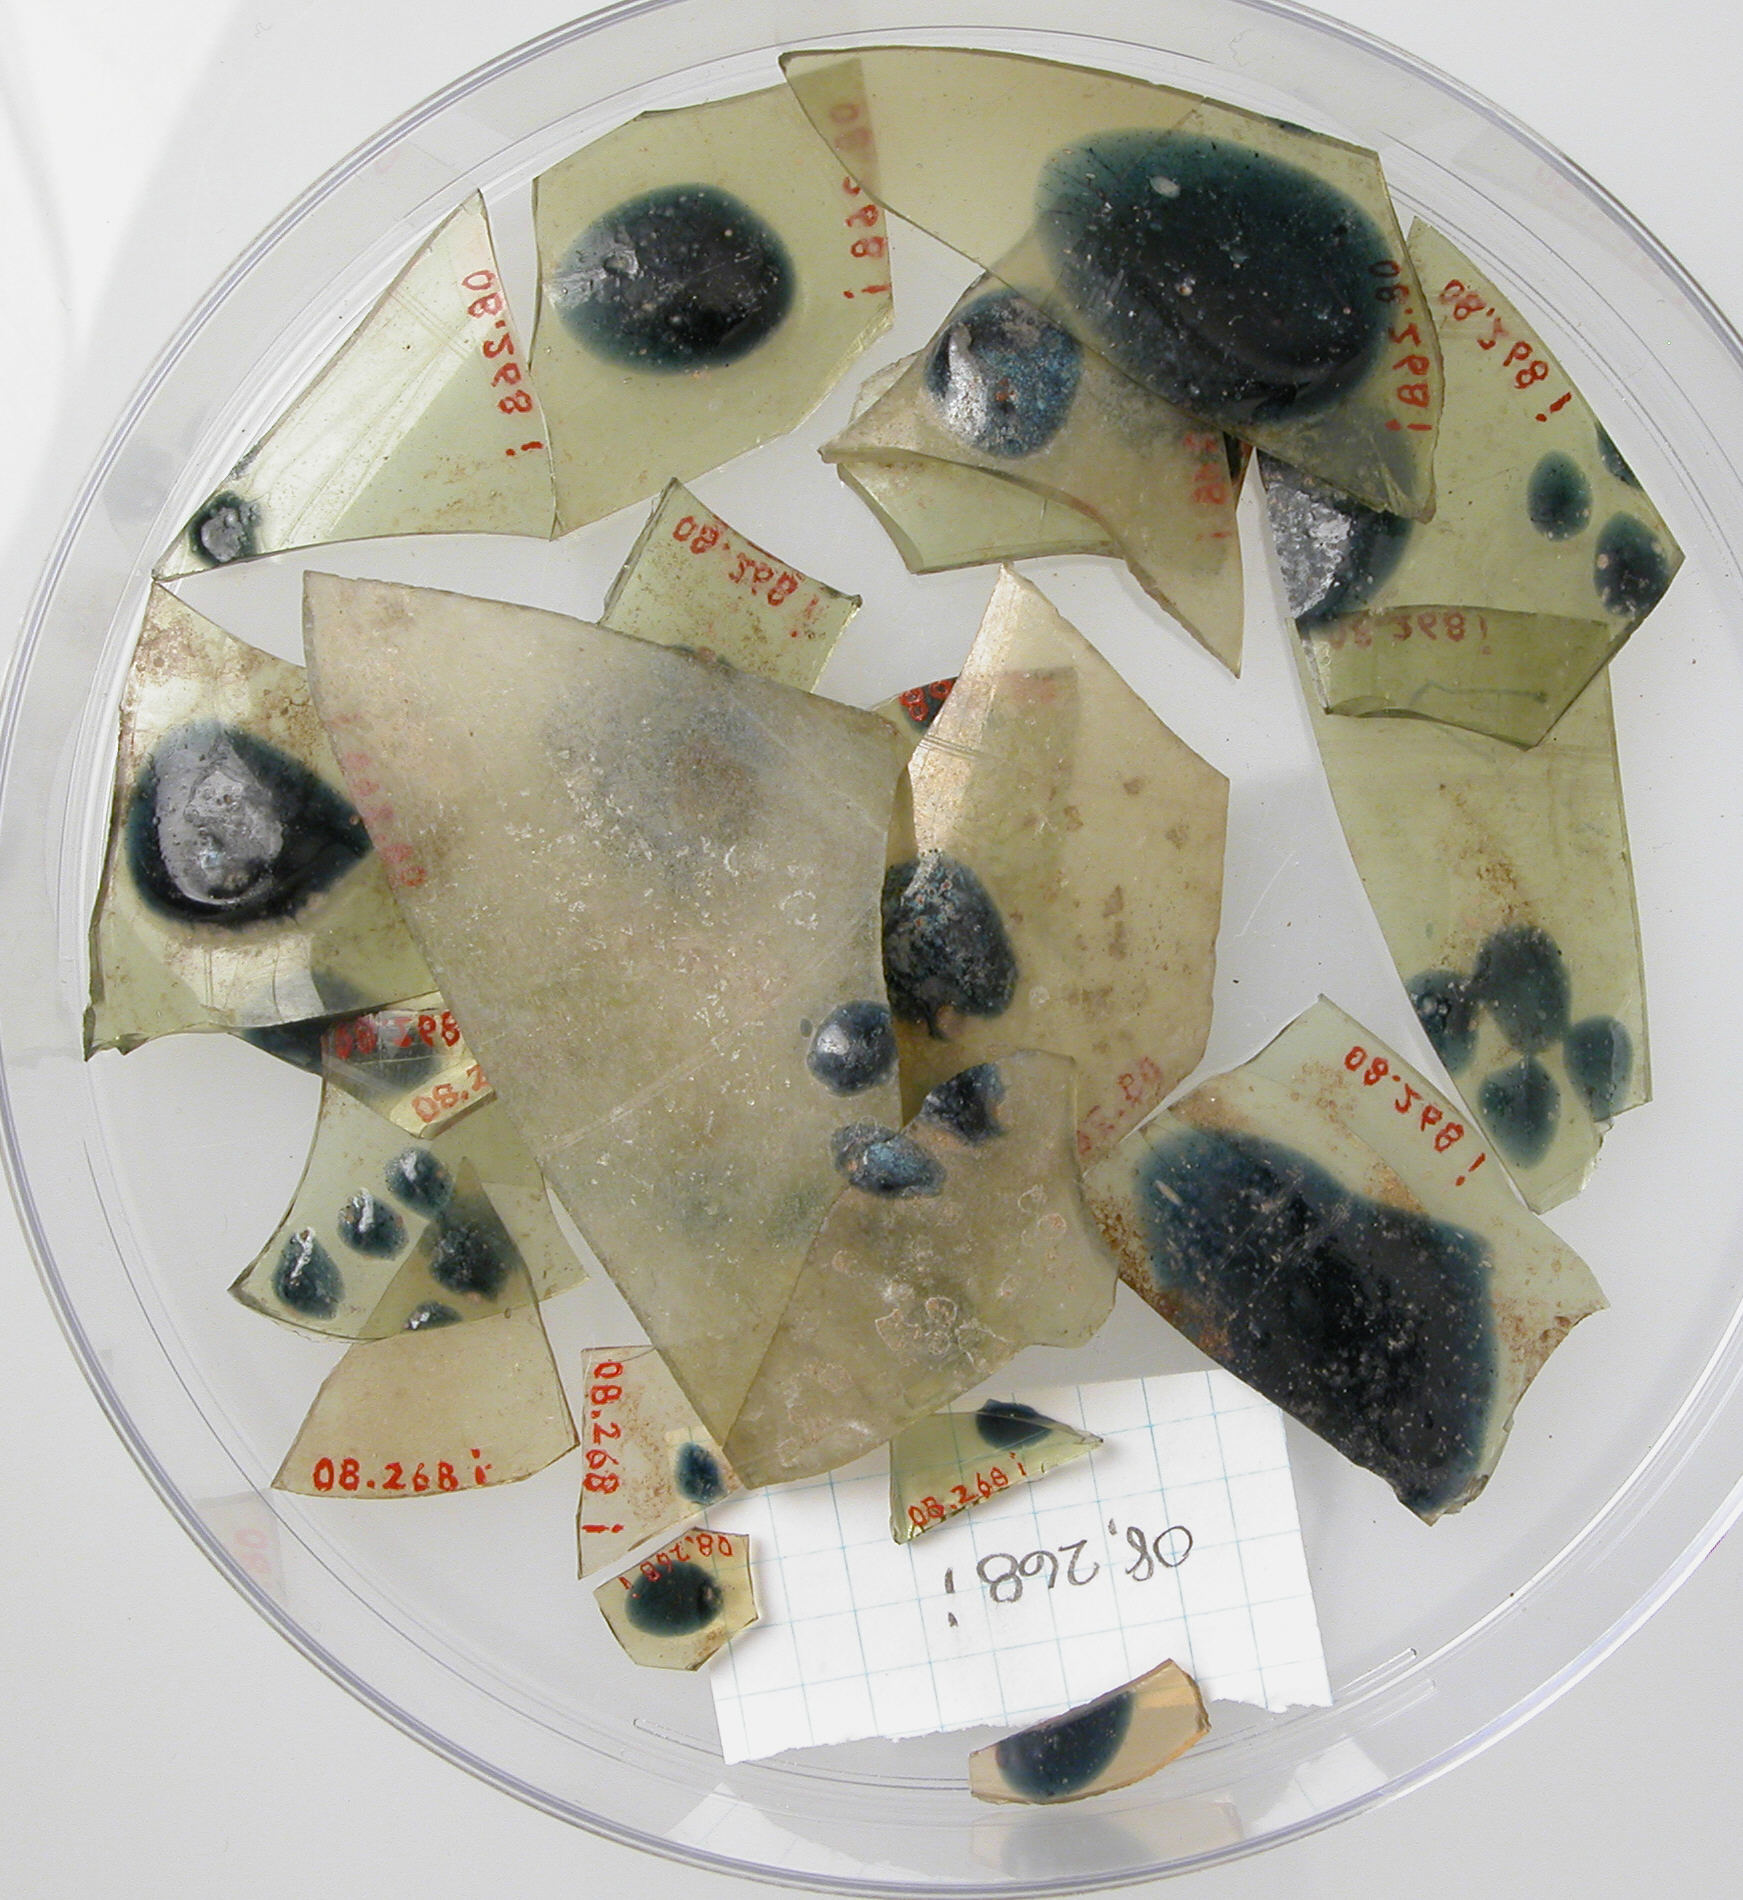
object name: fragment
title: Glass Fragments from a Vessel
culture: coptic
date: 301-433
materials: glass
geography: egypt